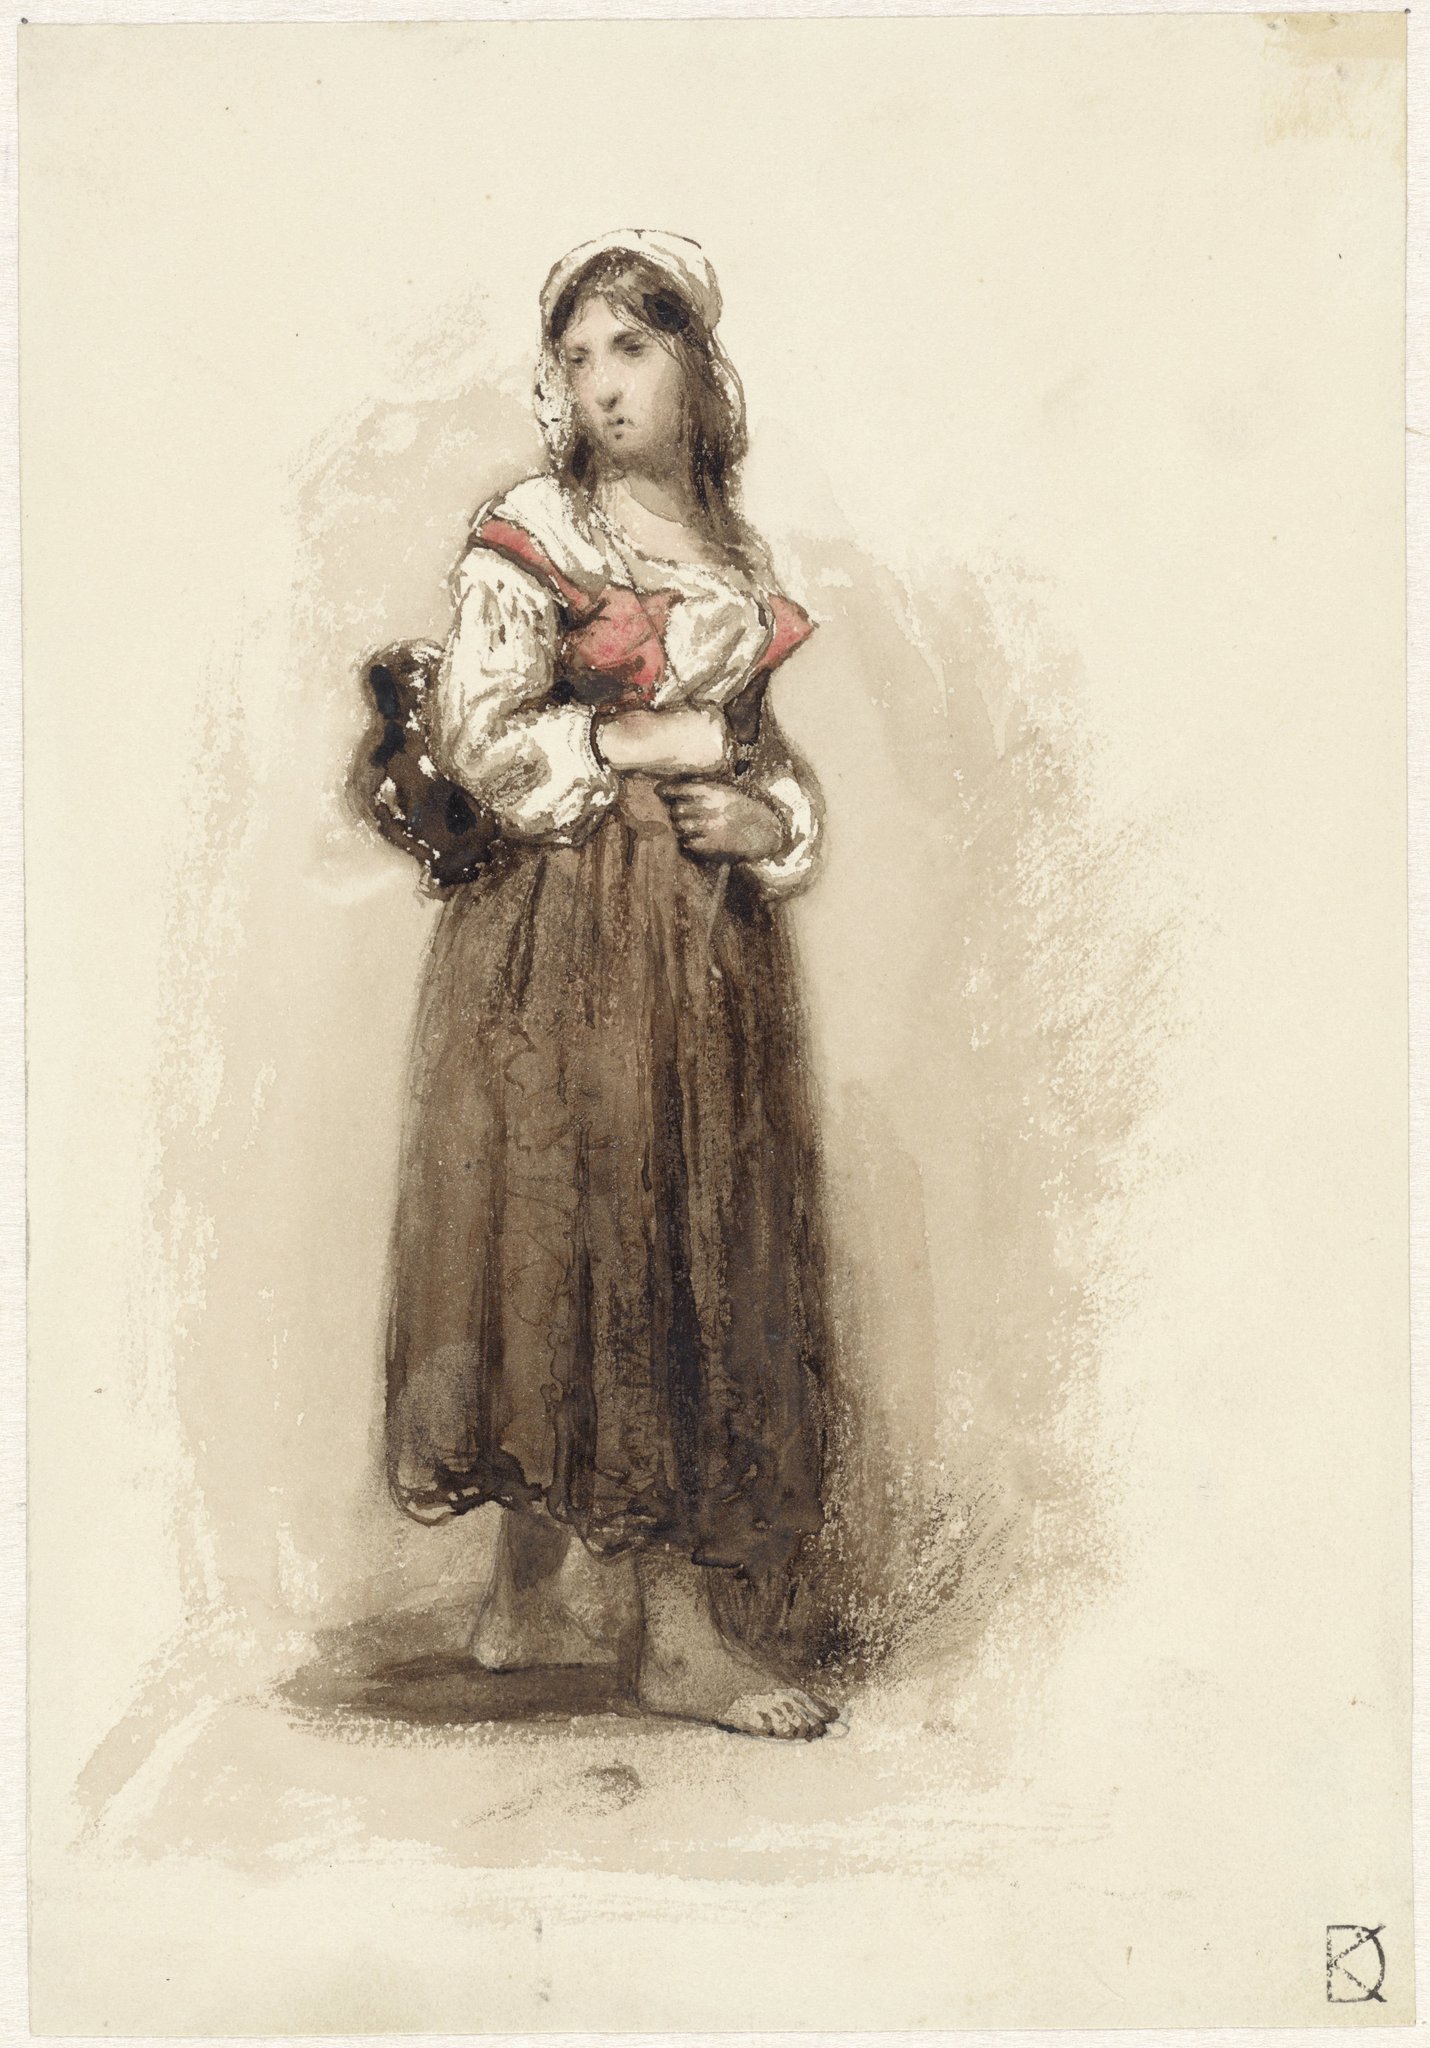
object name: watercolor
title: Staande meid met een kruik op de rug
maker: johan daniël koelman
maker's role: draughtsman, print maker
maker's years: 1831-1857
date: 1841-1857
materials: paper, watercolor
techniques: brush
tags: standing figure - aa - female human figure, container of ceramics: jar, jug, pot, vase